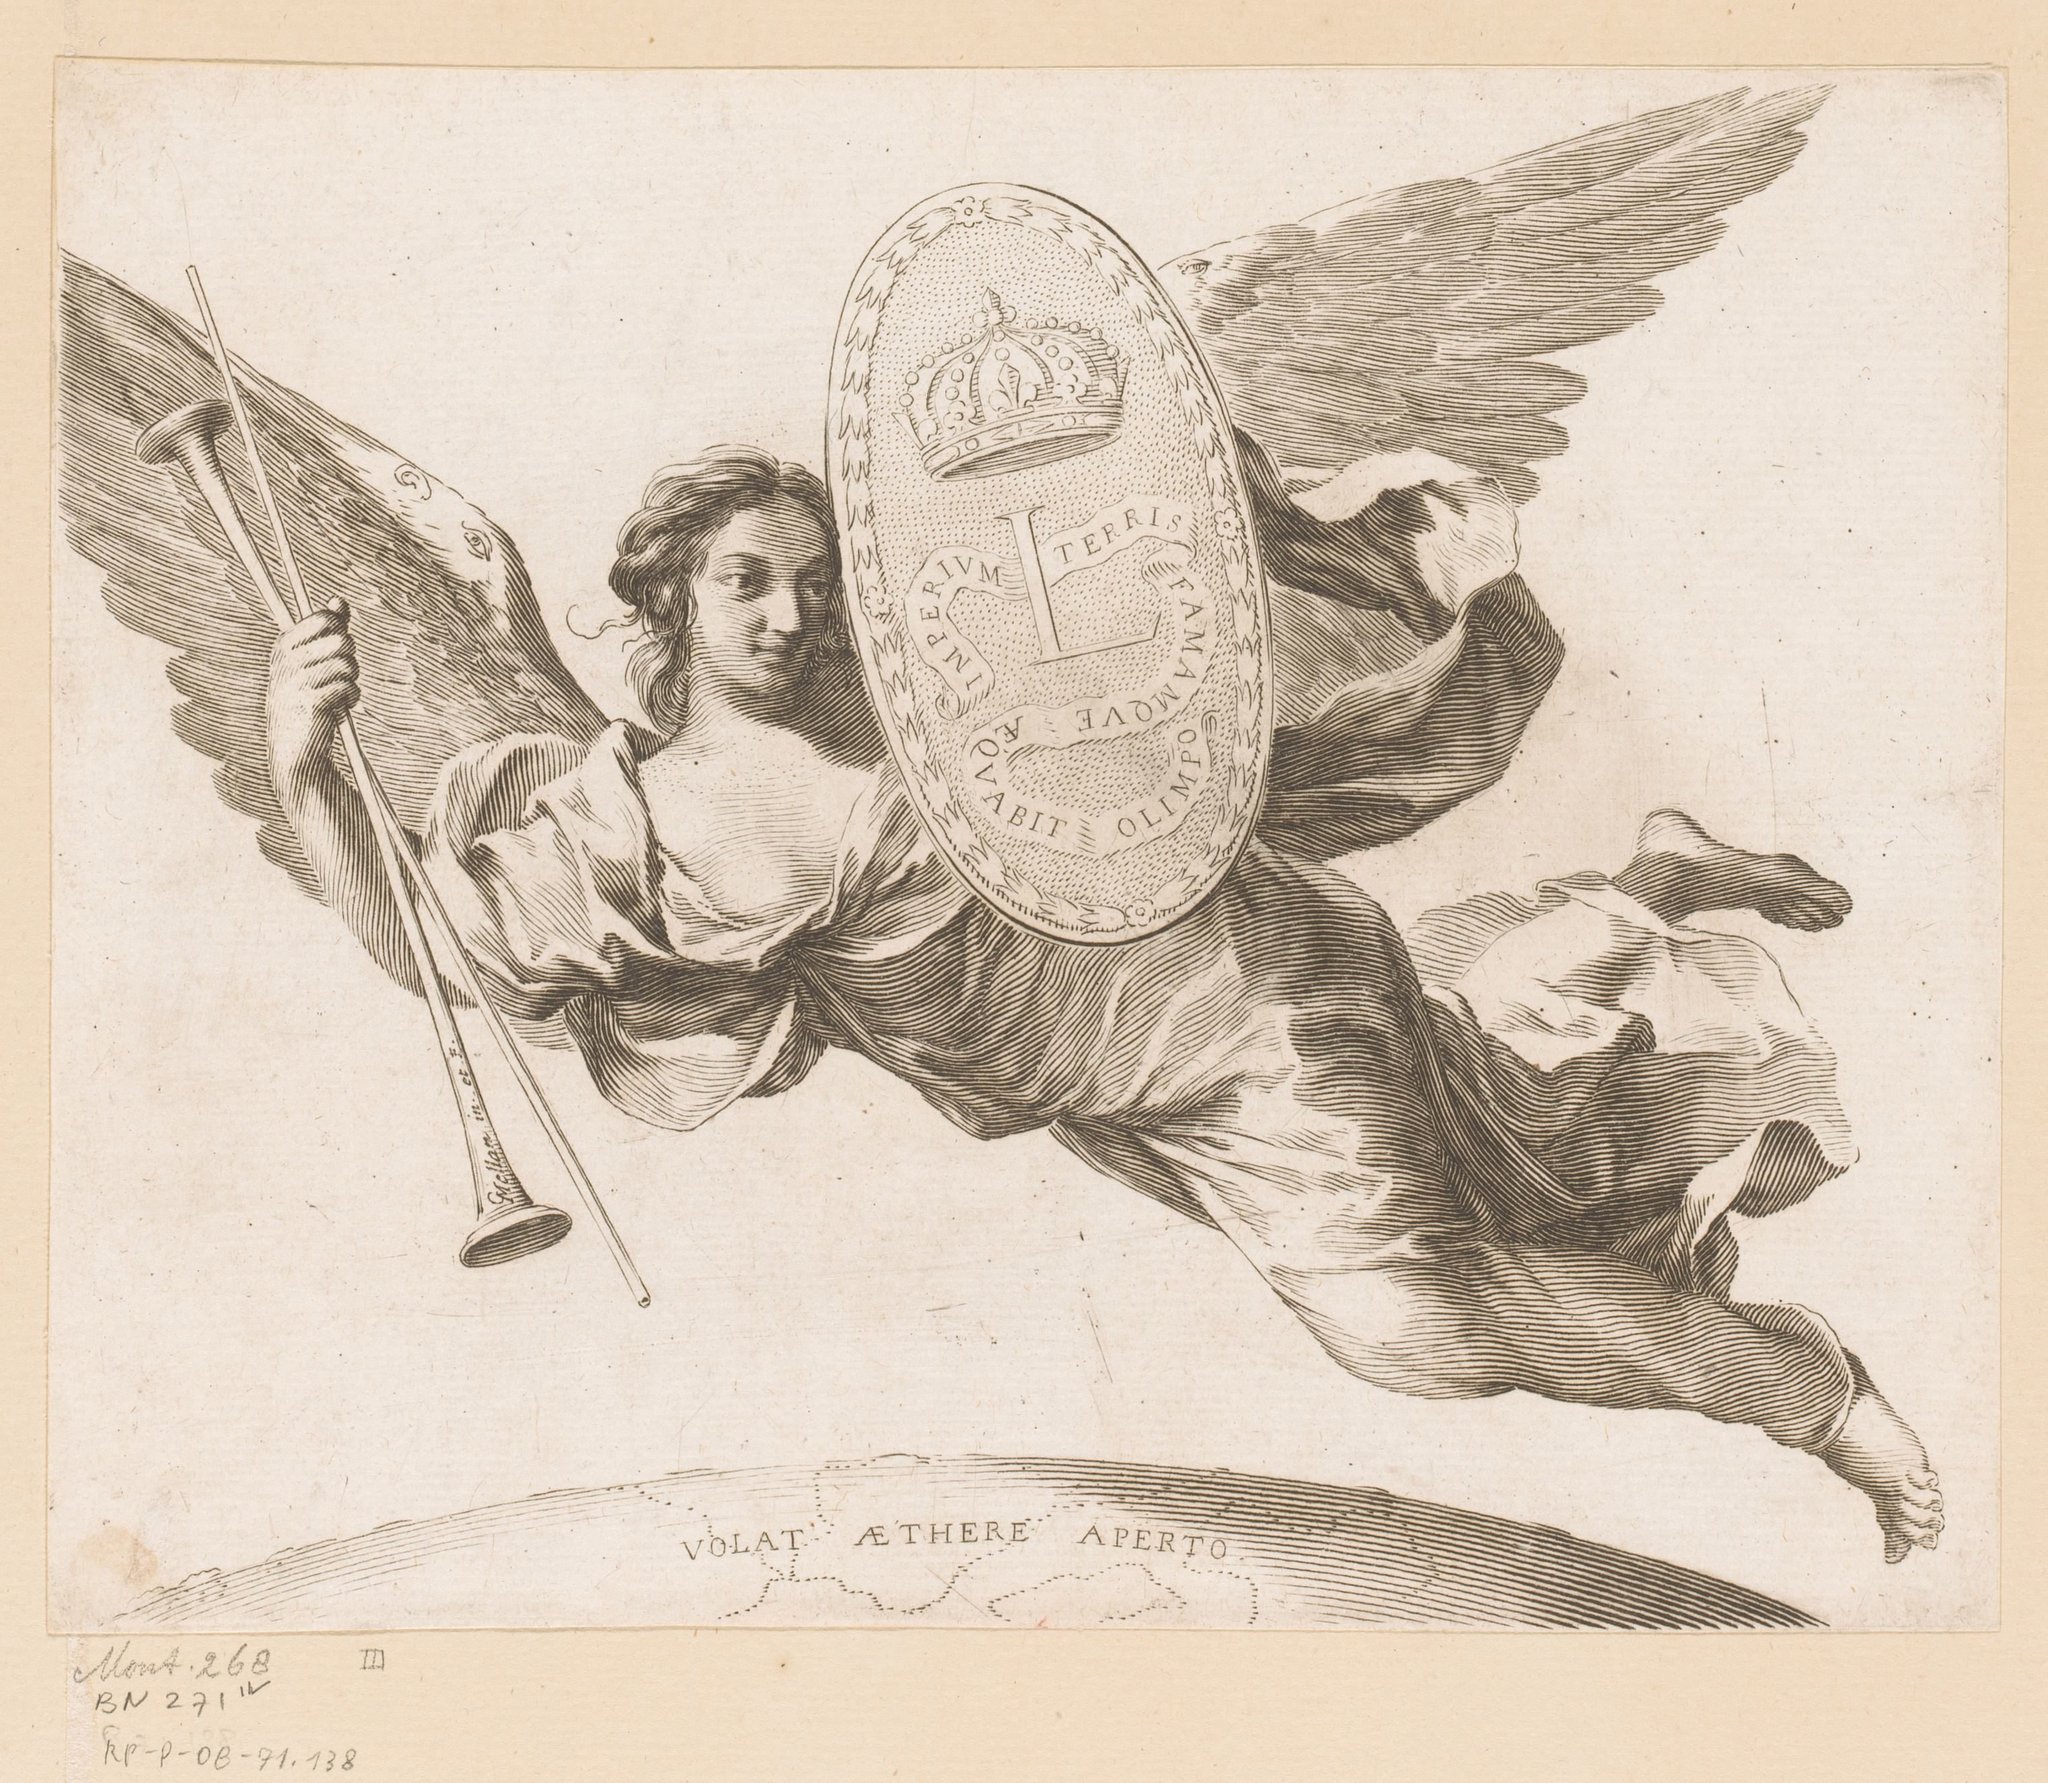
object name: print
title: Vrouwelijke figuur met vleugels en wapenschild van Jules Mazarin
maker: claude mellan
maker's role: draughtsman, print maker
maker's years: 1598-1688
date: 1608-1688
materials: paper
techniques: engraving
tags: jules mazarin, armorial bearing, heraldry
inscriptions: collector's mark: Lugt 240